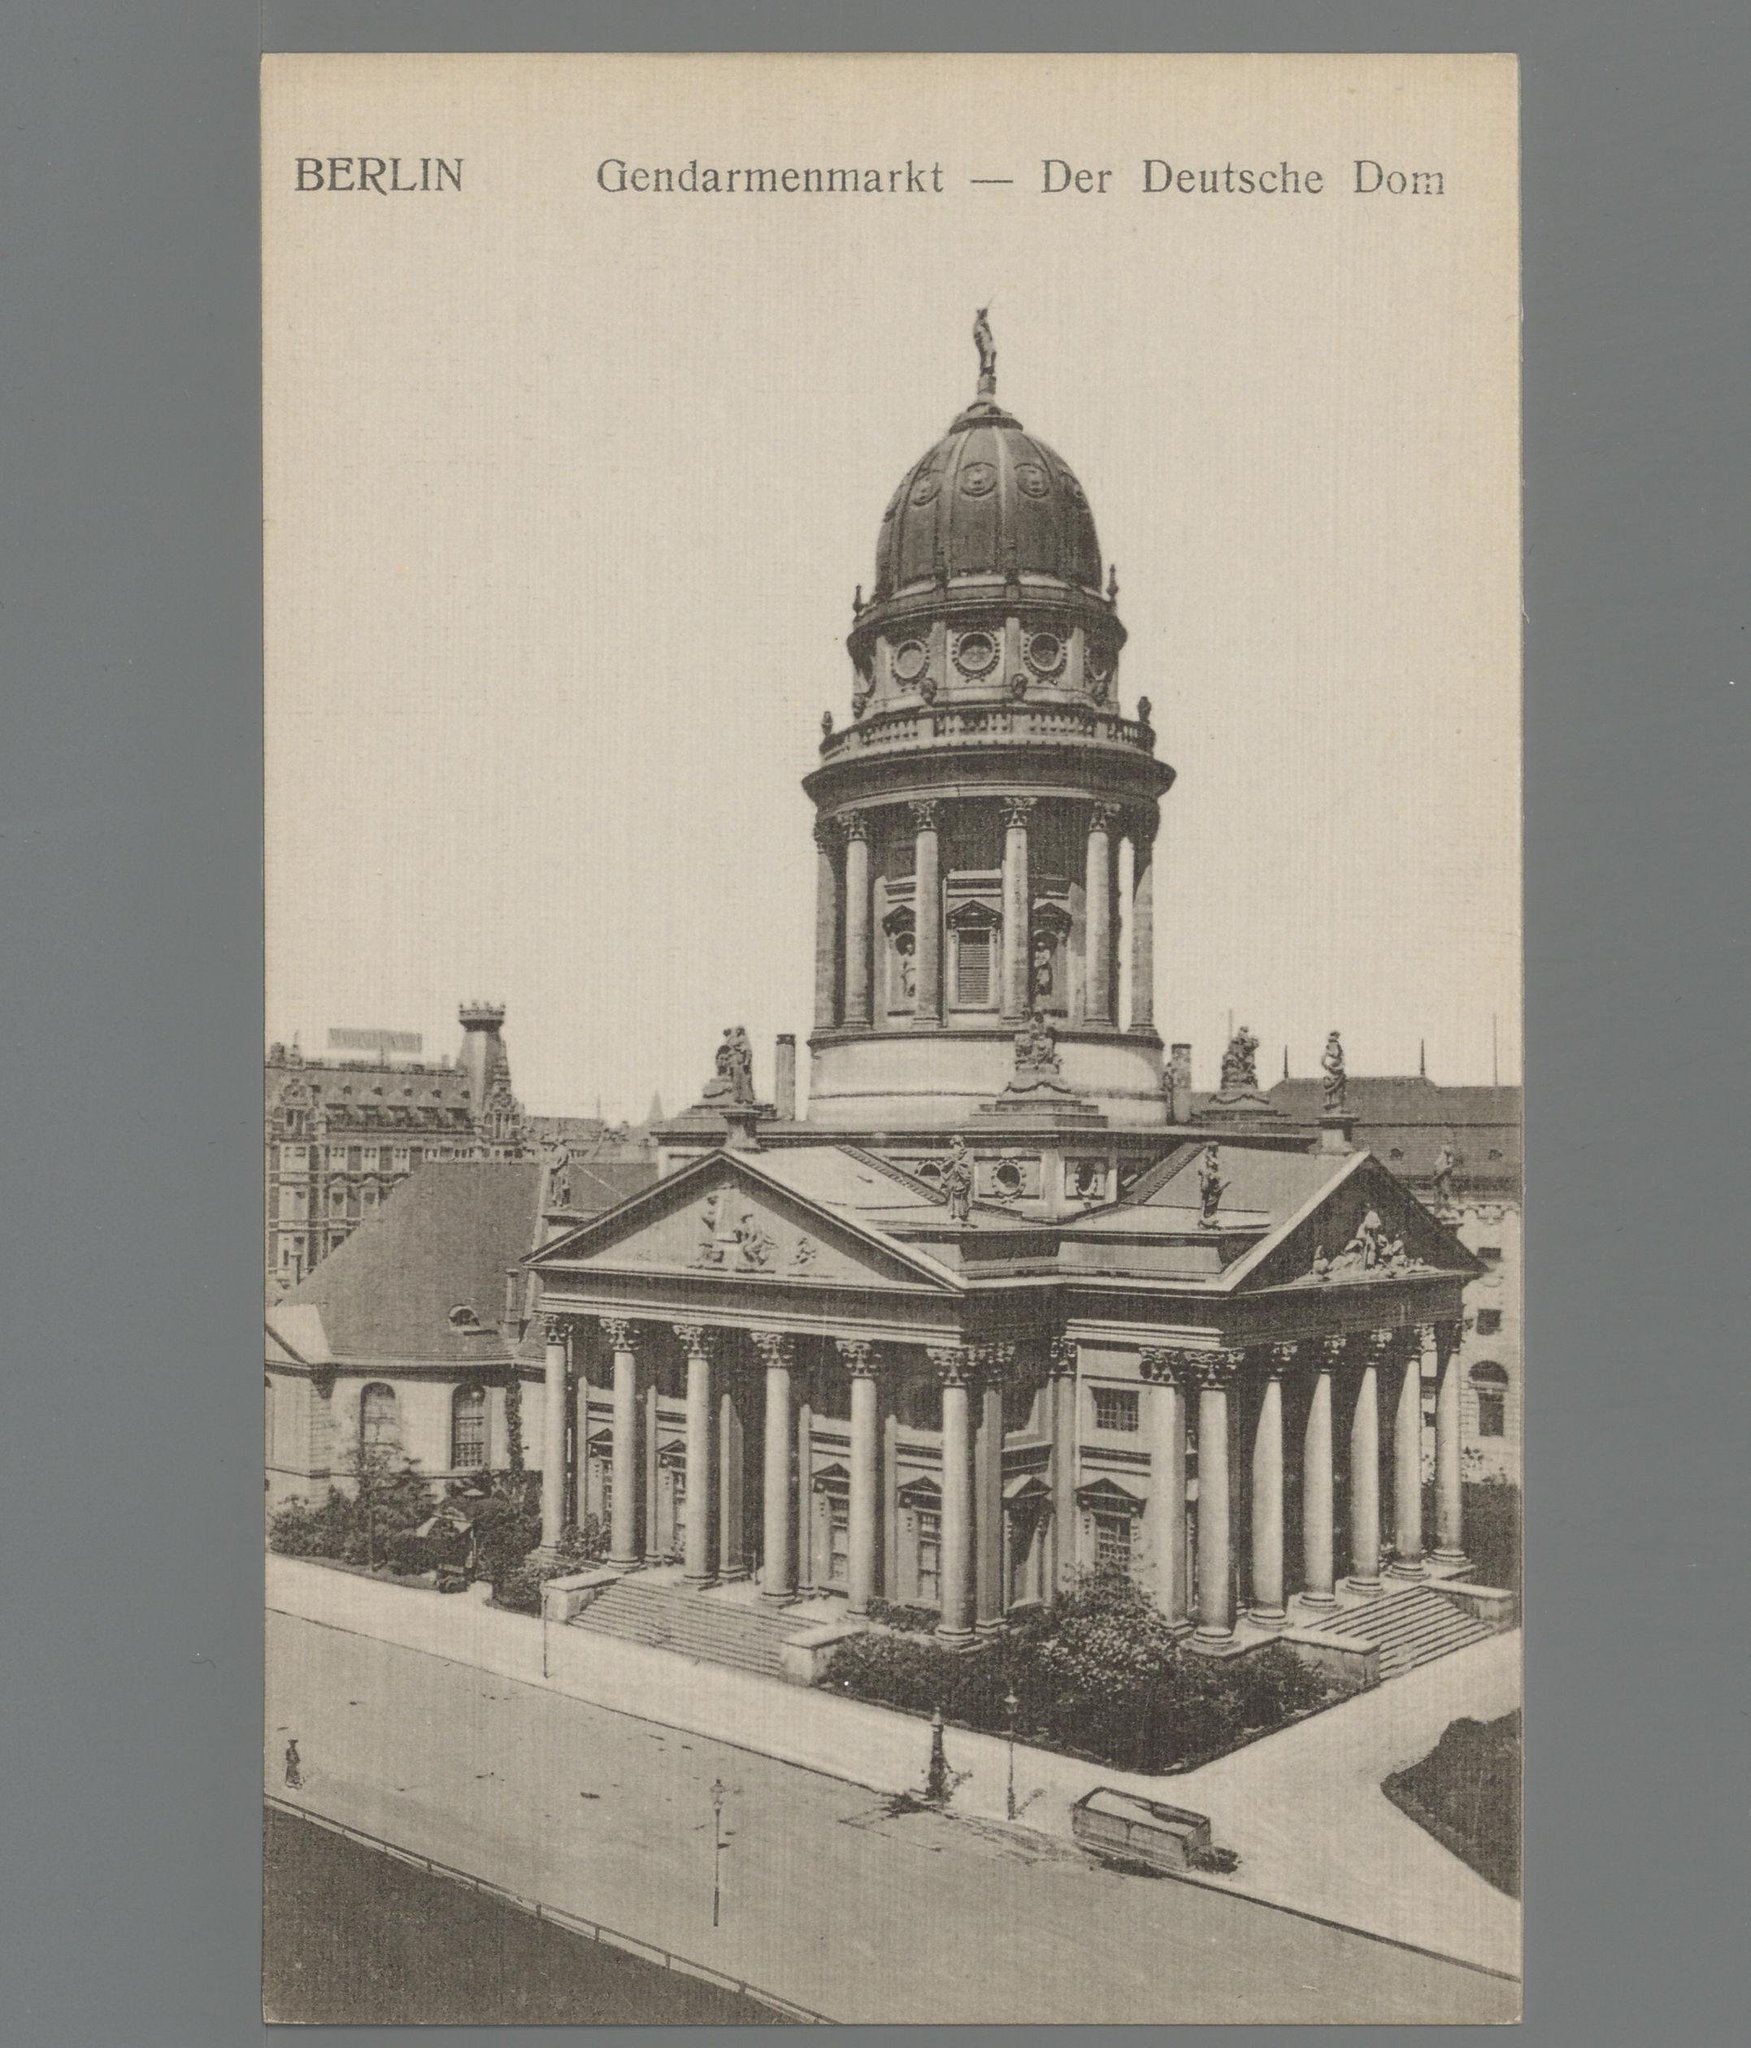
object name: ansichtkaart, prentbriefkaart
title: Berlin. Gendarmenmarkt - Der Deutsche Dom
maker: Anonymous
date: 1905-1930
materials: cardboard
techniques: photograph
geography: berlin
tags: church (exterior)